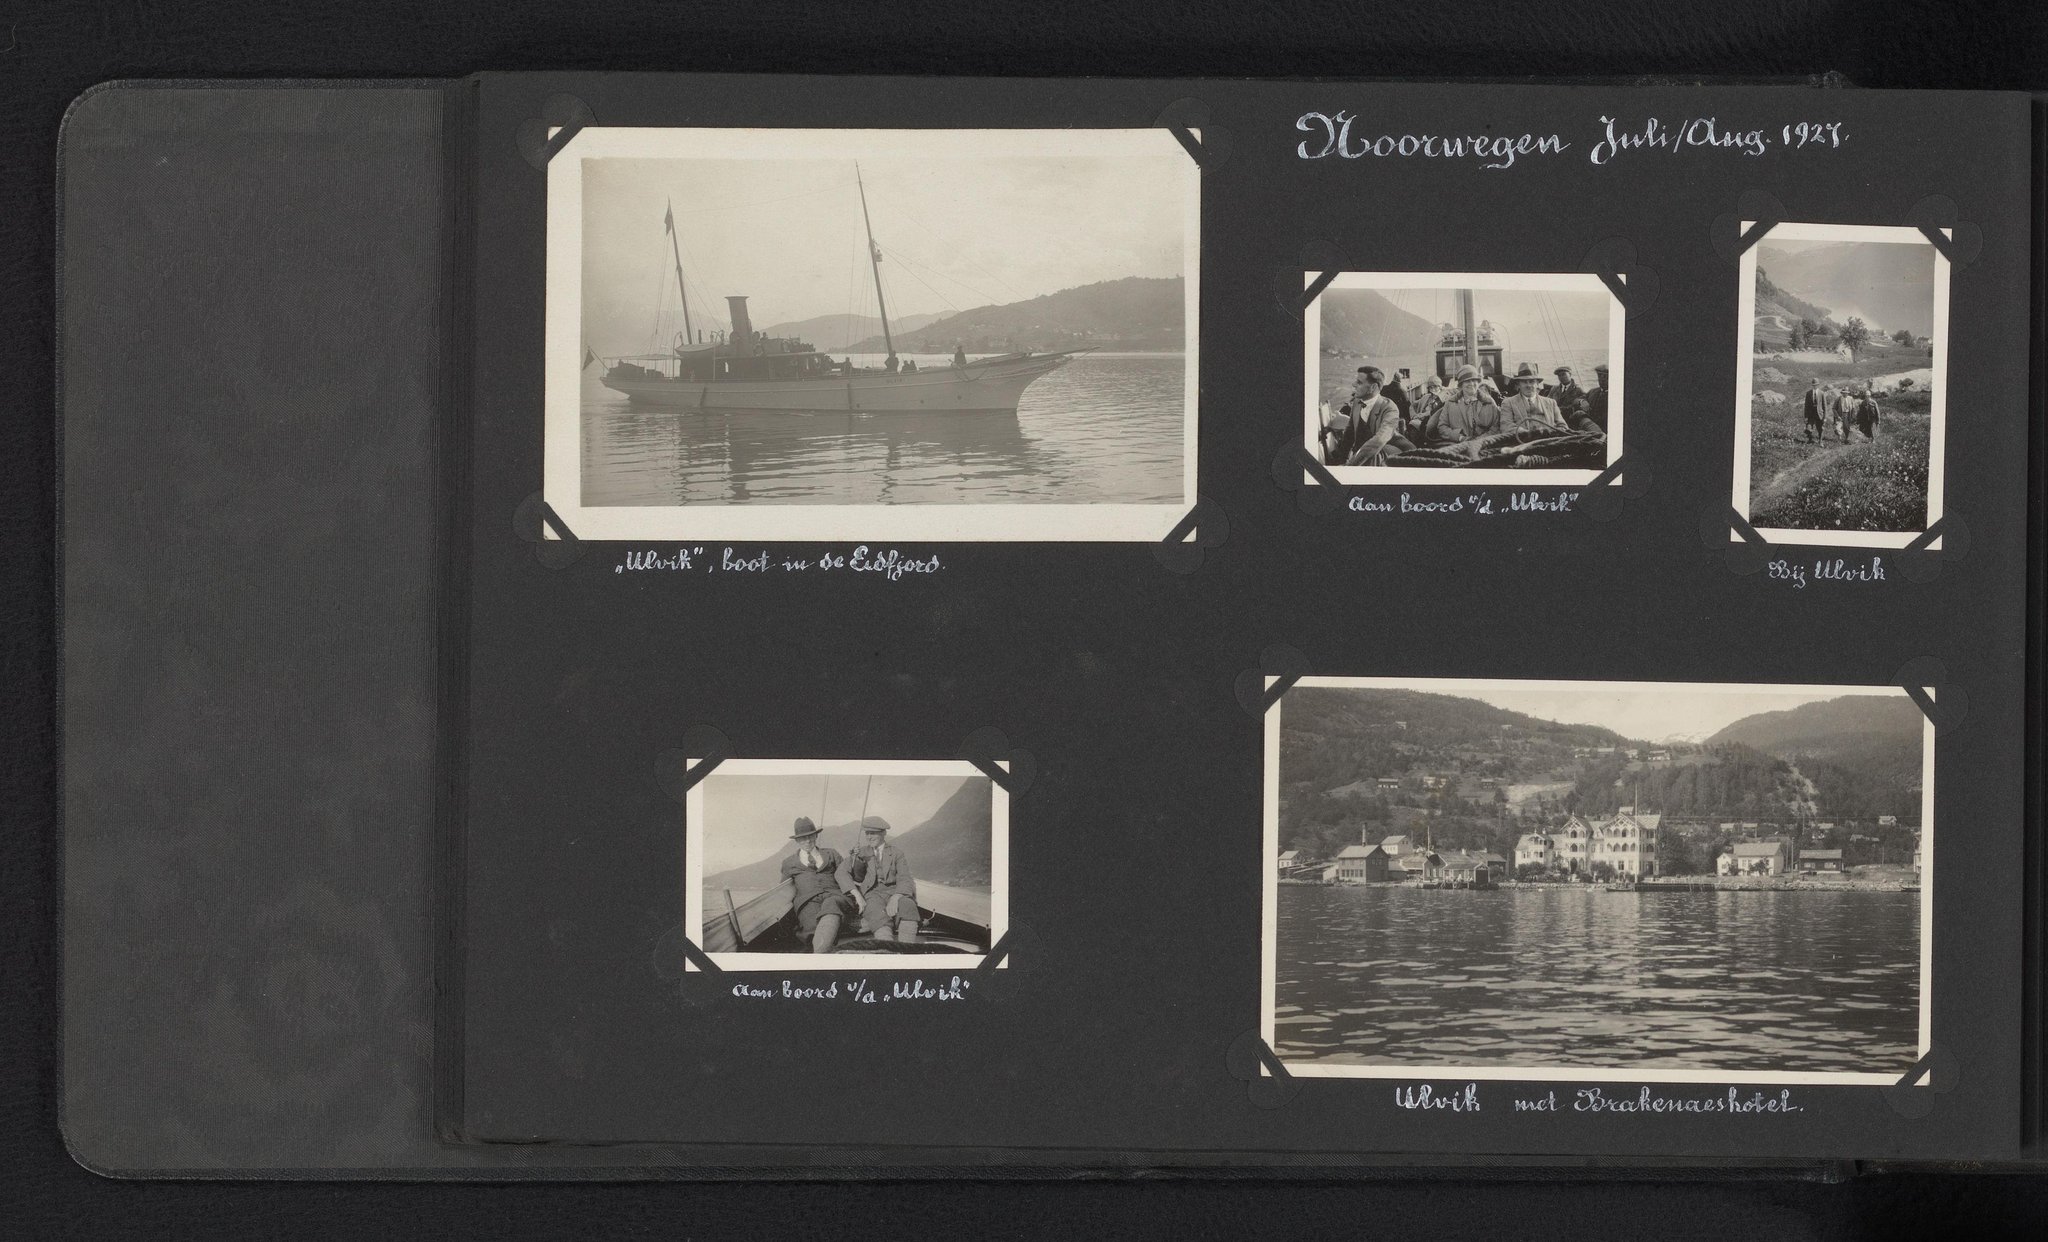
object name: photograph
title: Noorwegen Juli/Aug. 1927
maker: hendrik herman van den berg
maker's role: amateurfotograaf, jurist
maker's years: 1875-1944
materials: paper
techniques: gelatin silver print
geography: ulvik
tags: batavia, hendrik herman van den berg, the hague, caroline louise van den berg-van den berg, amsterdam, carel frederik van den berg (cay), frank willem van den berg (1912-1998), city-view in general; 'veduta', steamship, motorship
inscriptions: inscription: ‘"Ulvik", boot in de Eindfjord’, inscription: ‘Aan boord v/d "Ulvik"’, inscription: ‘Aan boord v/d "Ulvik"’, inscription: ‘Ulvik met Brakenaeshotel’, inscription: ‘Bij Ulvik’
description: Deze foto's maken deel uit van een album.